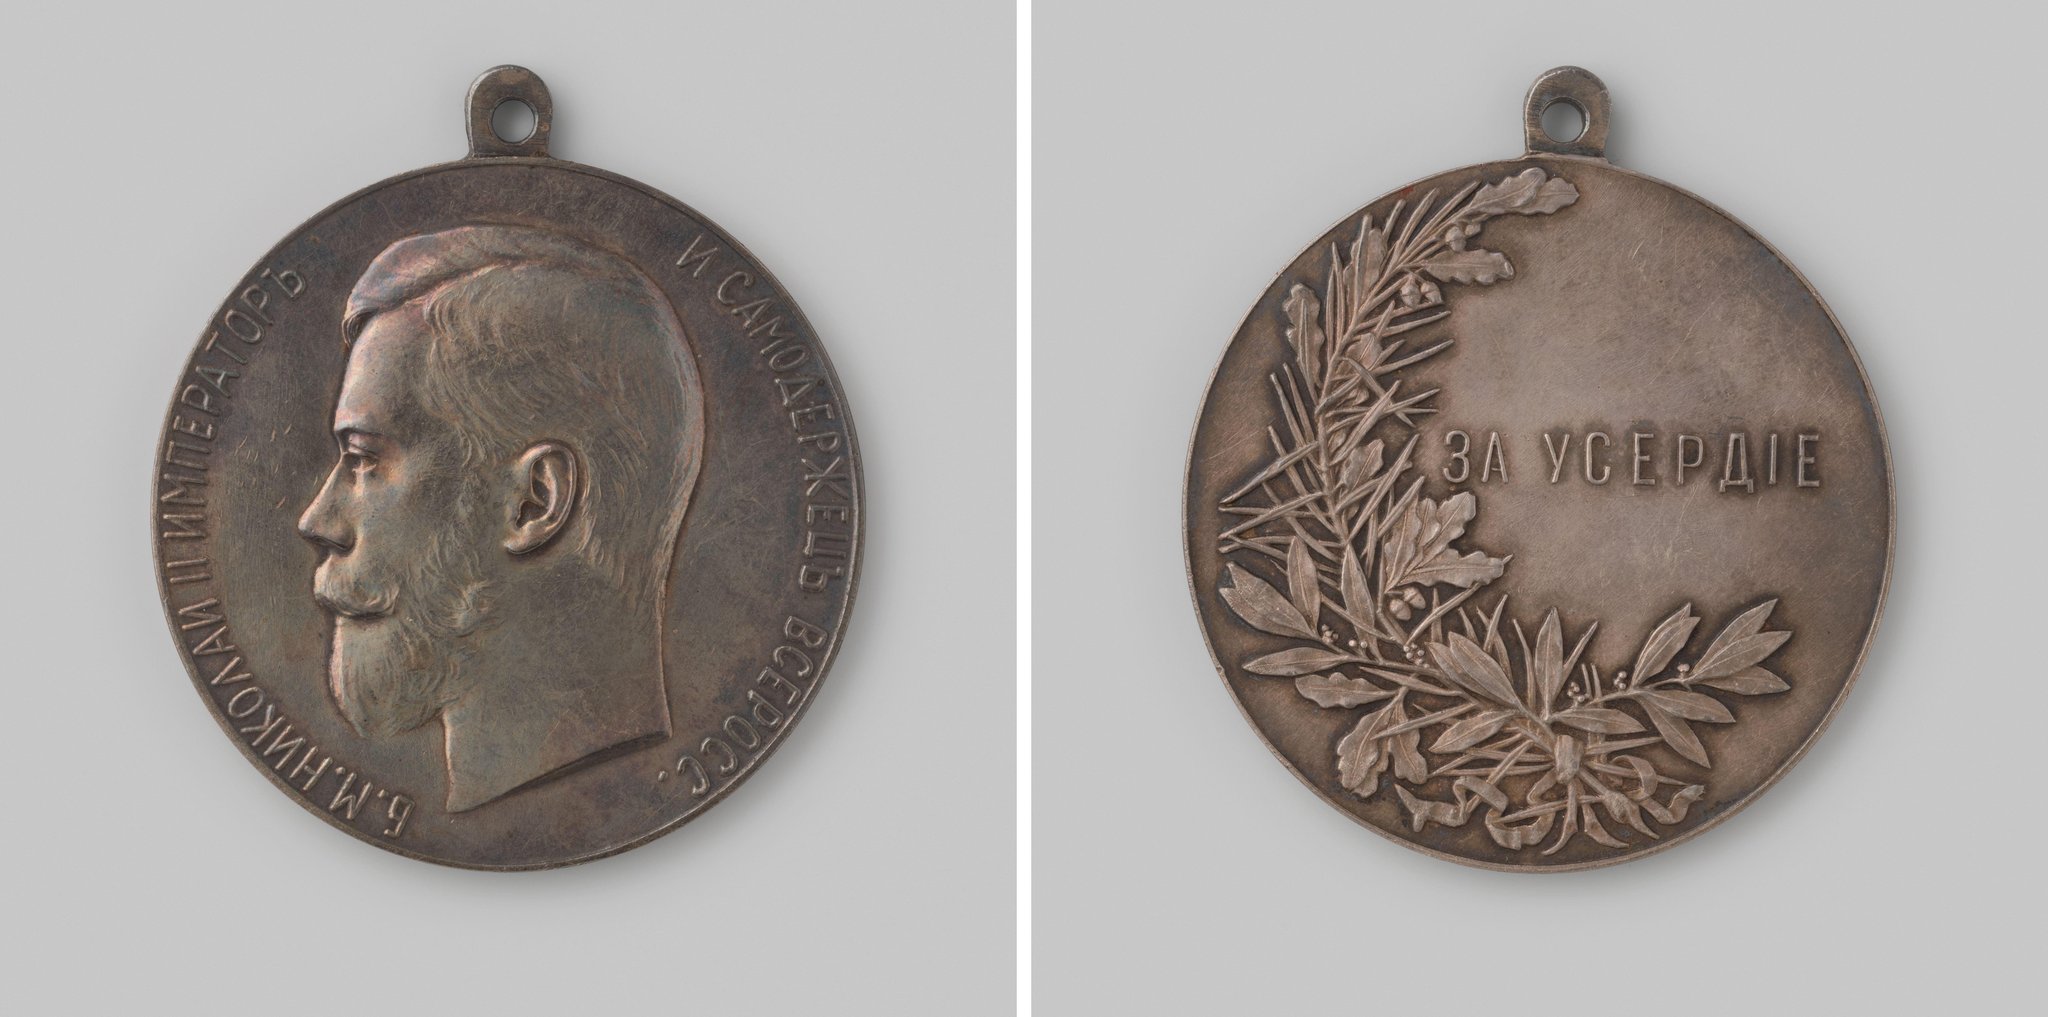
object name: history medal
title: Russische beloningspenning 1906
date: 1906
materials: silver, textile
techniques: striking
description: Zilveren penning met draagoog, op de voorzijde het portret van Tsaar Alexander III naar links met omschrift, op de keerzijde één regel tekst met links daarvan samengestrikte lauwer-, palm- en eikentakken. Los hierbij een rood lint met beiderzijds twee witte biezen.